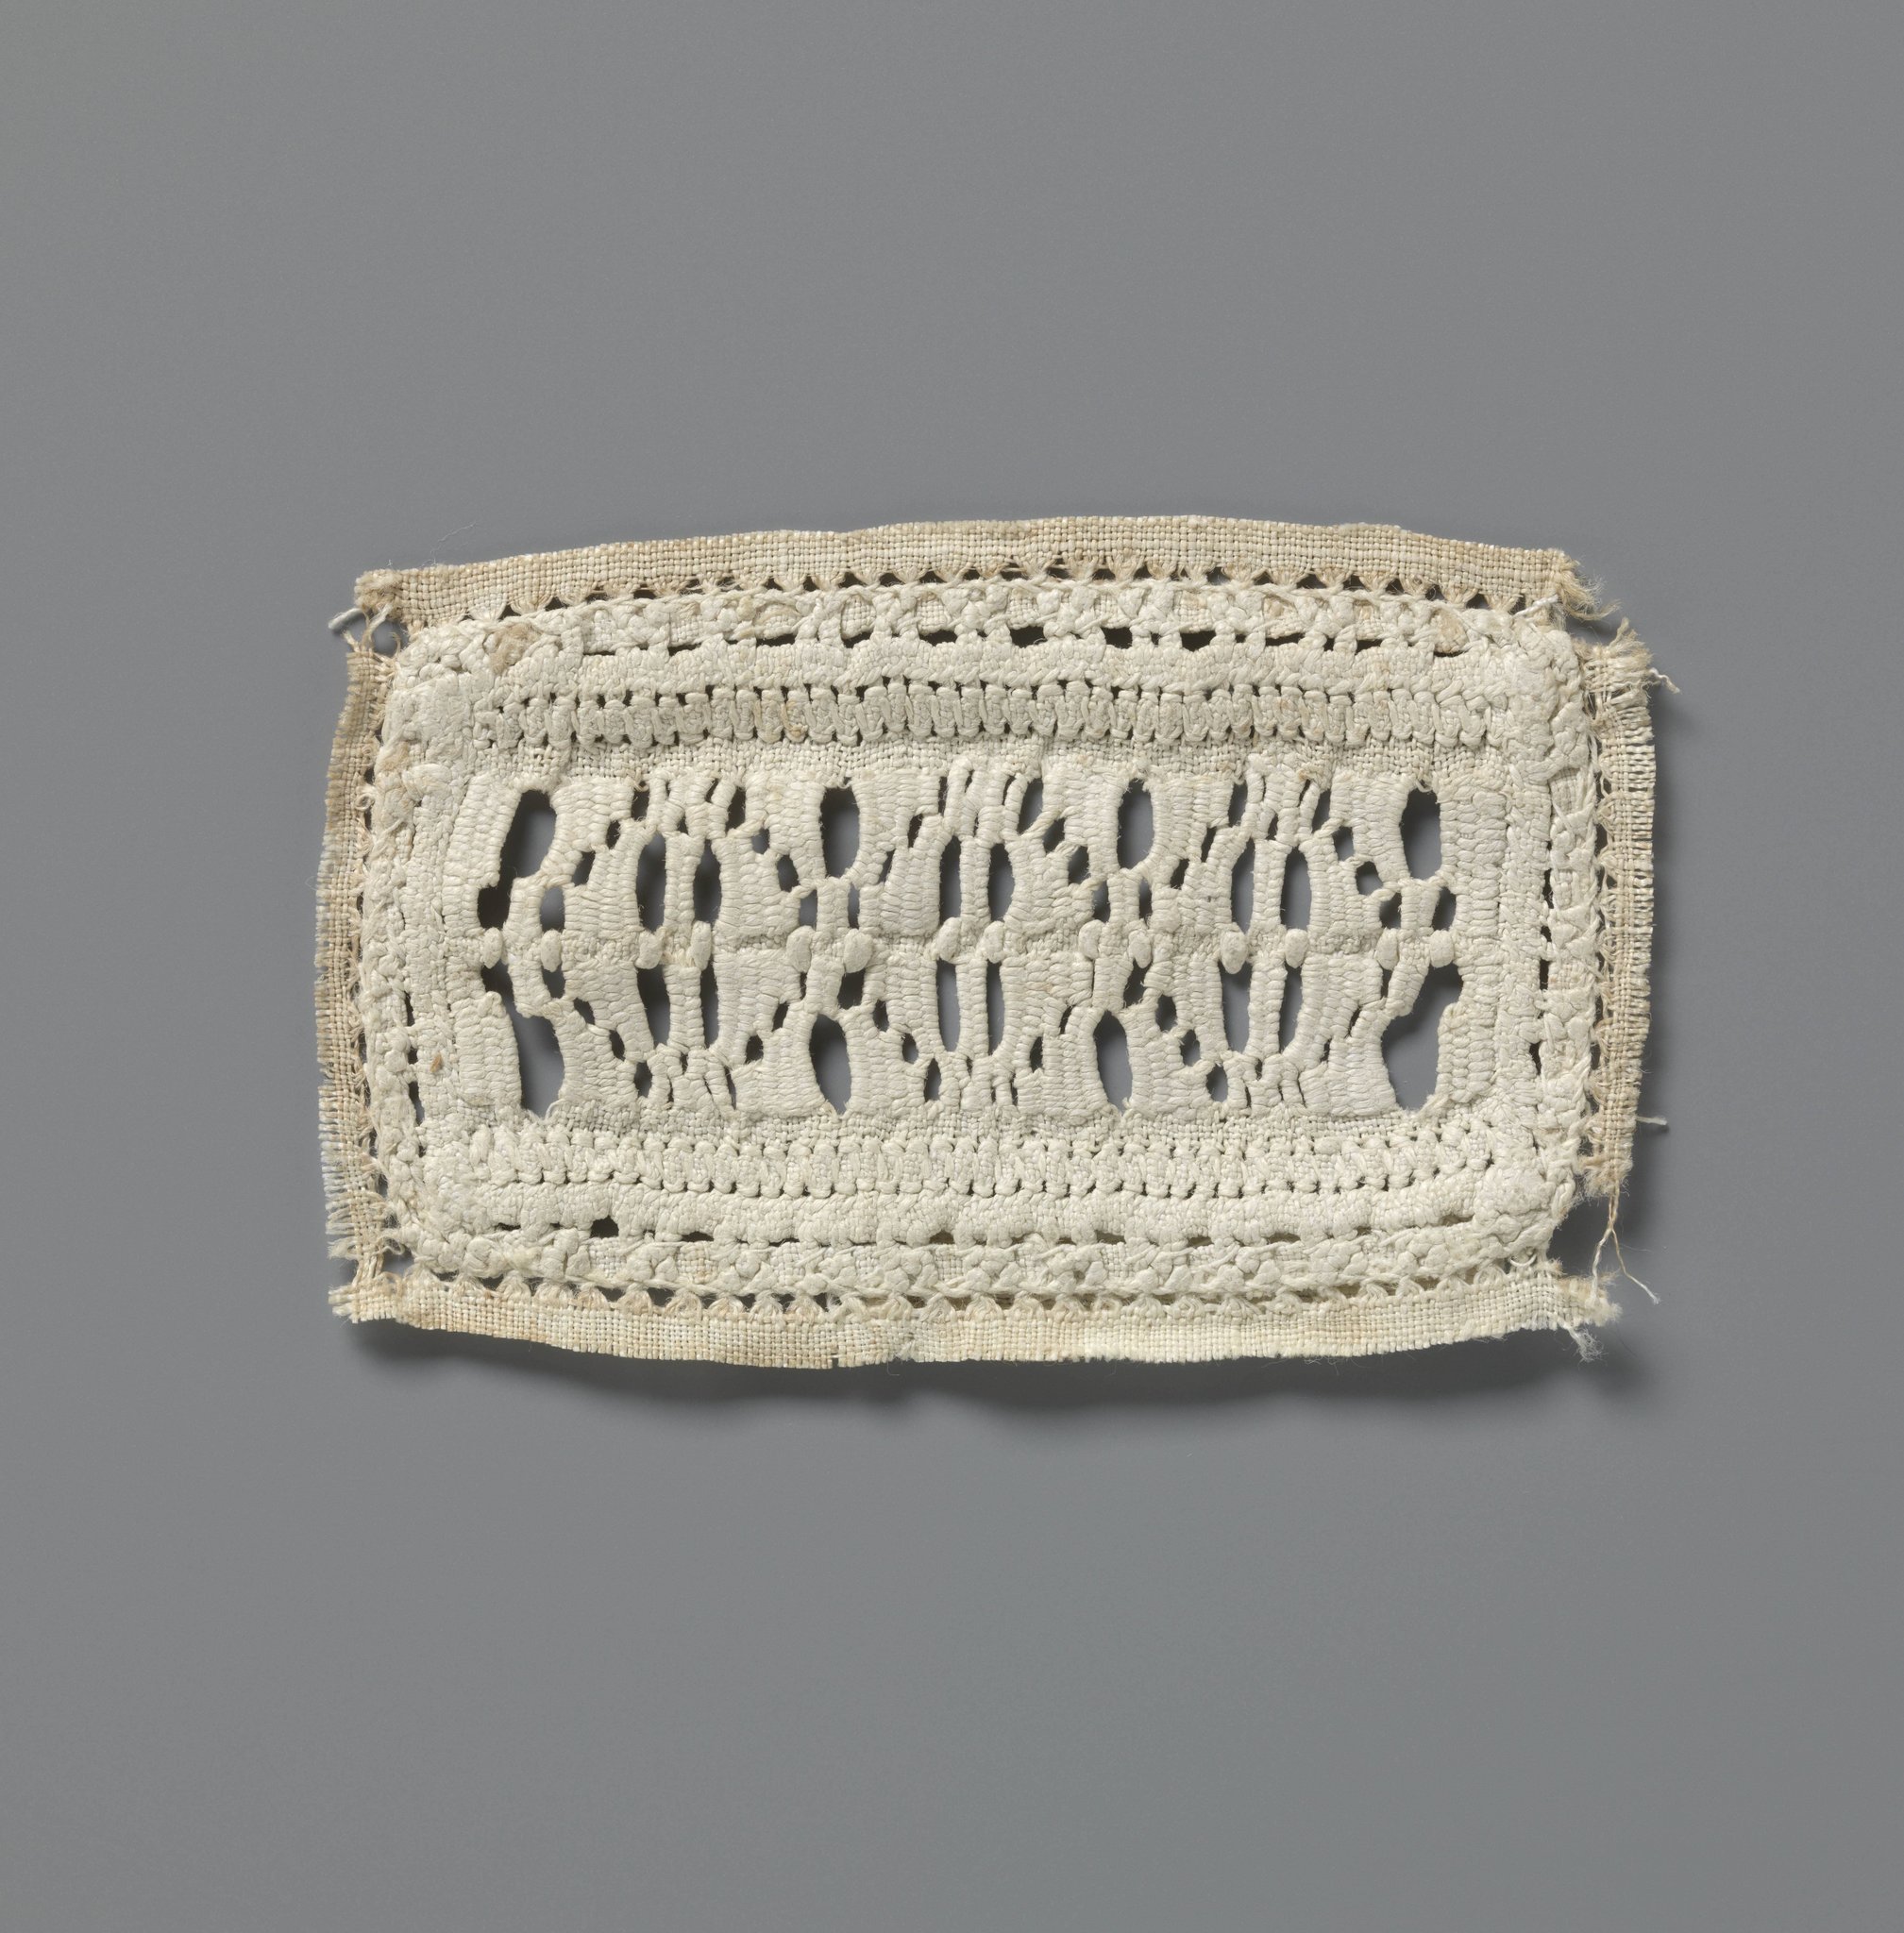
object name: strip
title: Strook open naaiwerk met drie ruiten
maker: Anonymous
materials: linen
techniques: openwork embroidery, work with drawn threads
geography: west indies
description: Strook naturelkleurig open naaiwerk: werk met uitgetrokken draden. Het patroon met drie ruiten gemaakt door openingen in het rechthoekige stukje textiel. In het centrum van de ruiten vier langwerpige openingen. Boven en onder het punt waar de ruiten elkaar raken ook twee langwerpige openingen. Het patroon met de ruiten wordt met meerdere sierranden, waaronder een zigzagrand, met kleine openingen omlijst. De openingen in dit textiel zijn ontstaan door het uittrekken van draden. Rond de overgebleven draden zijn steken geborduurd.